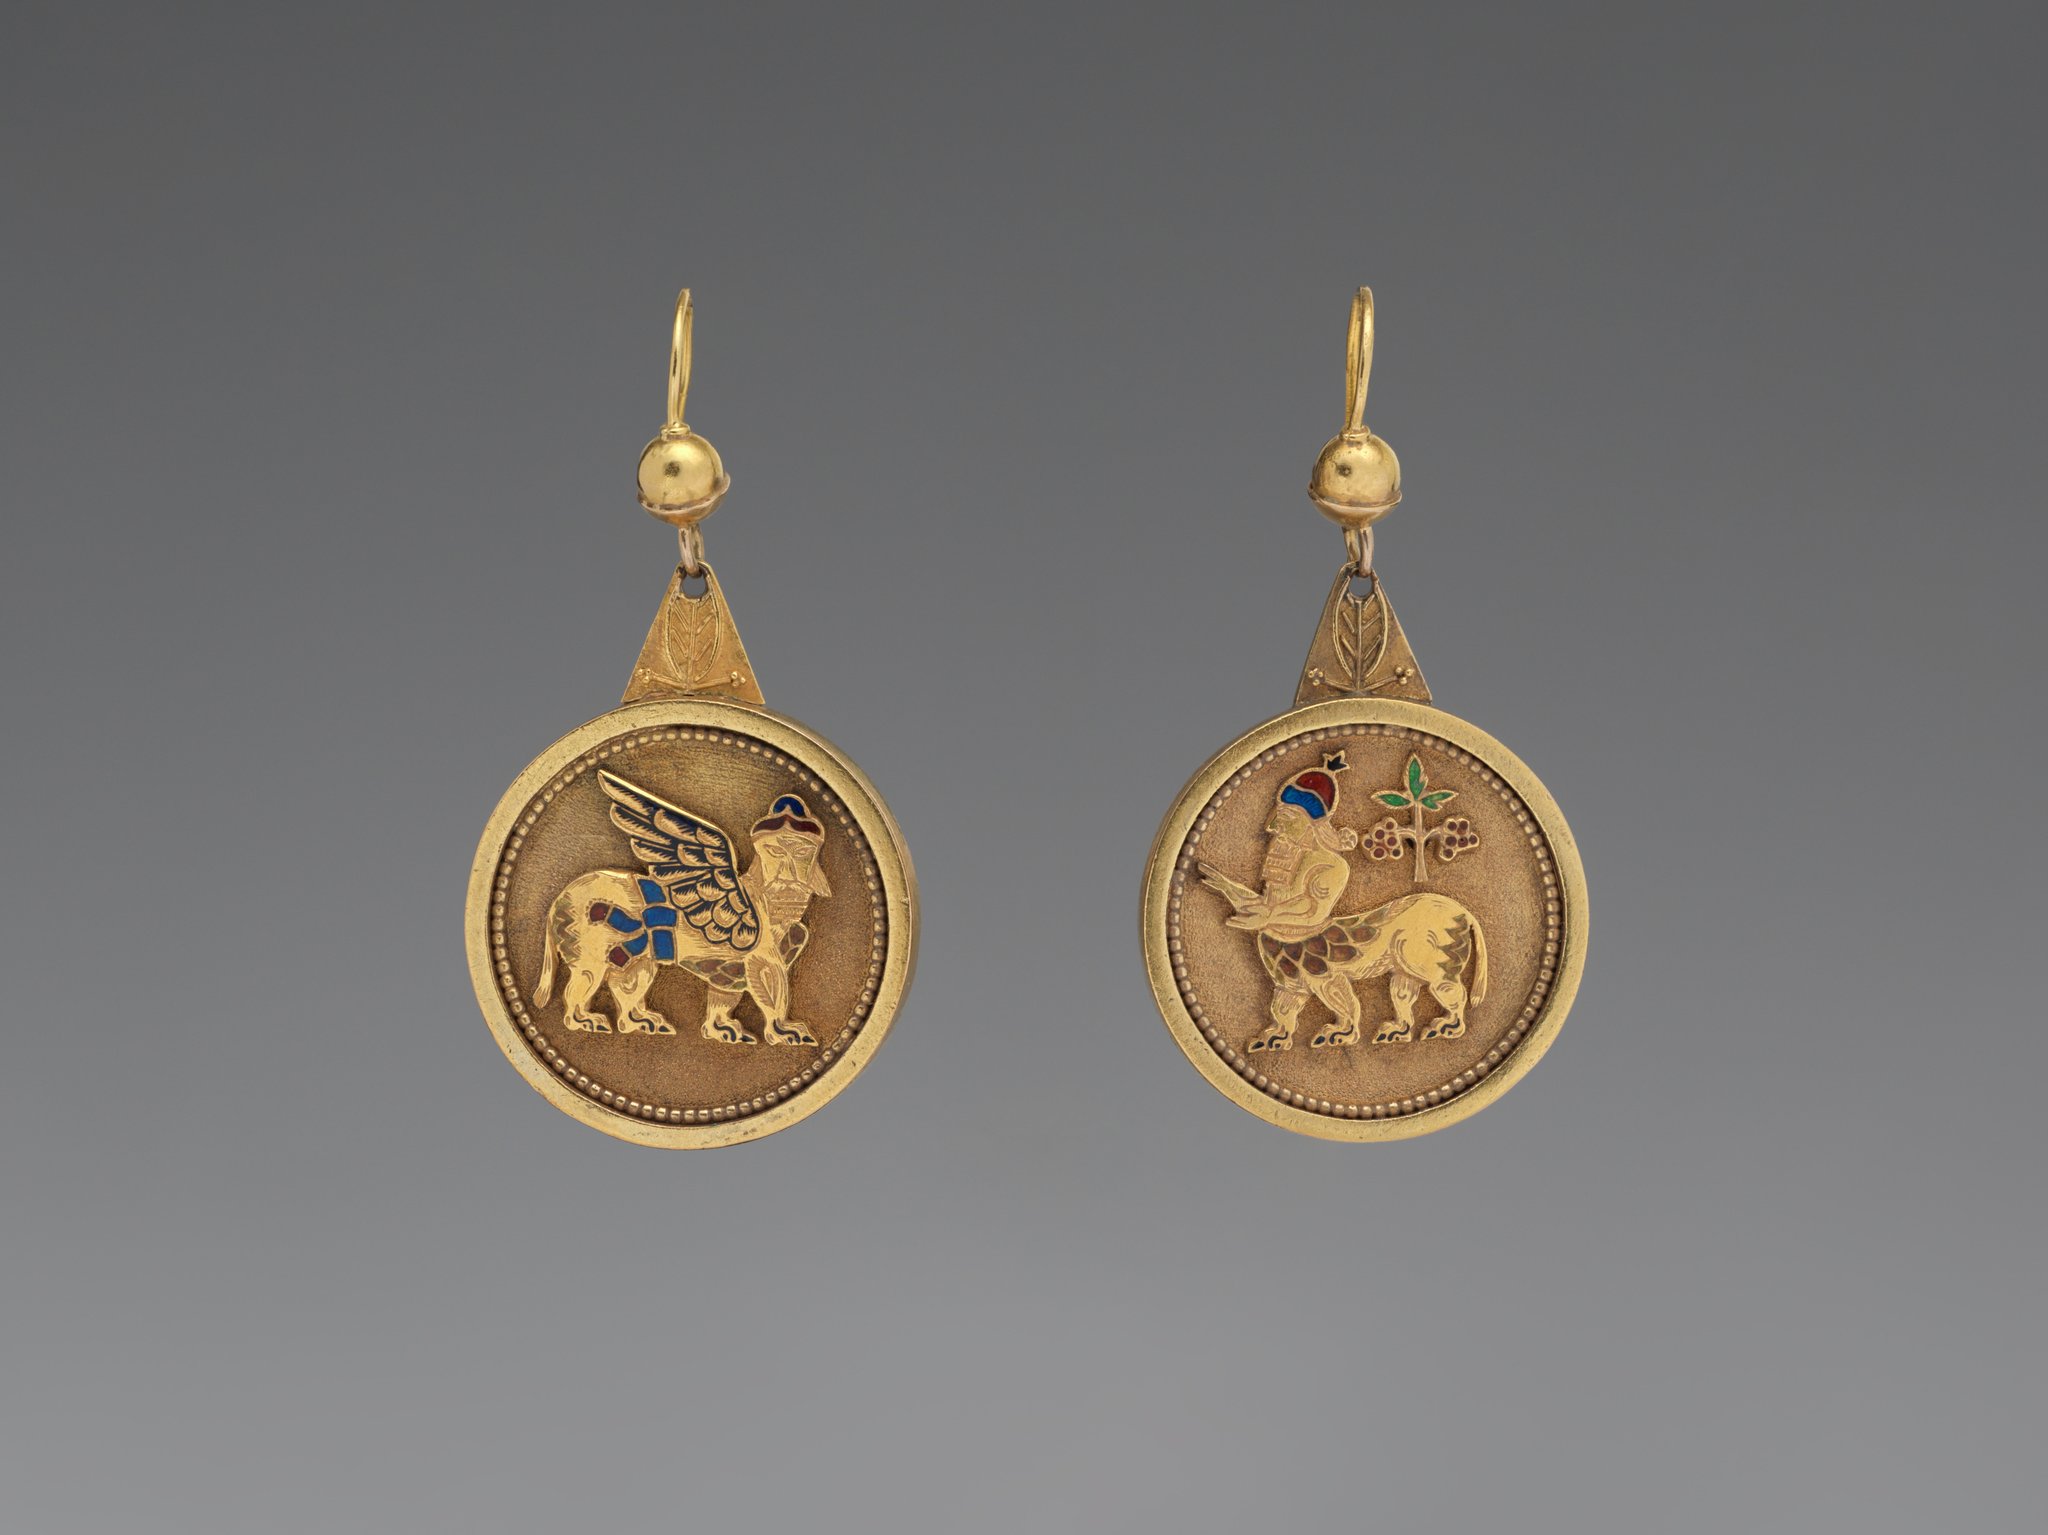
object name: earring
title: Earrings with Assyrian motifs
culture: british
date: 1850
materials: enamel, gold